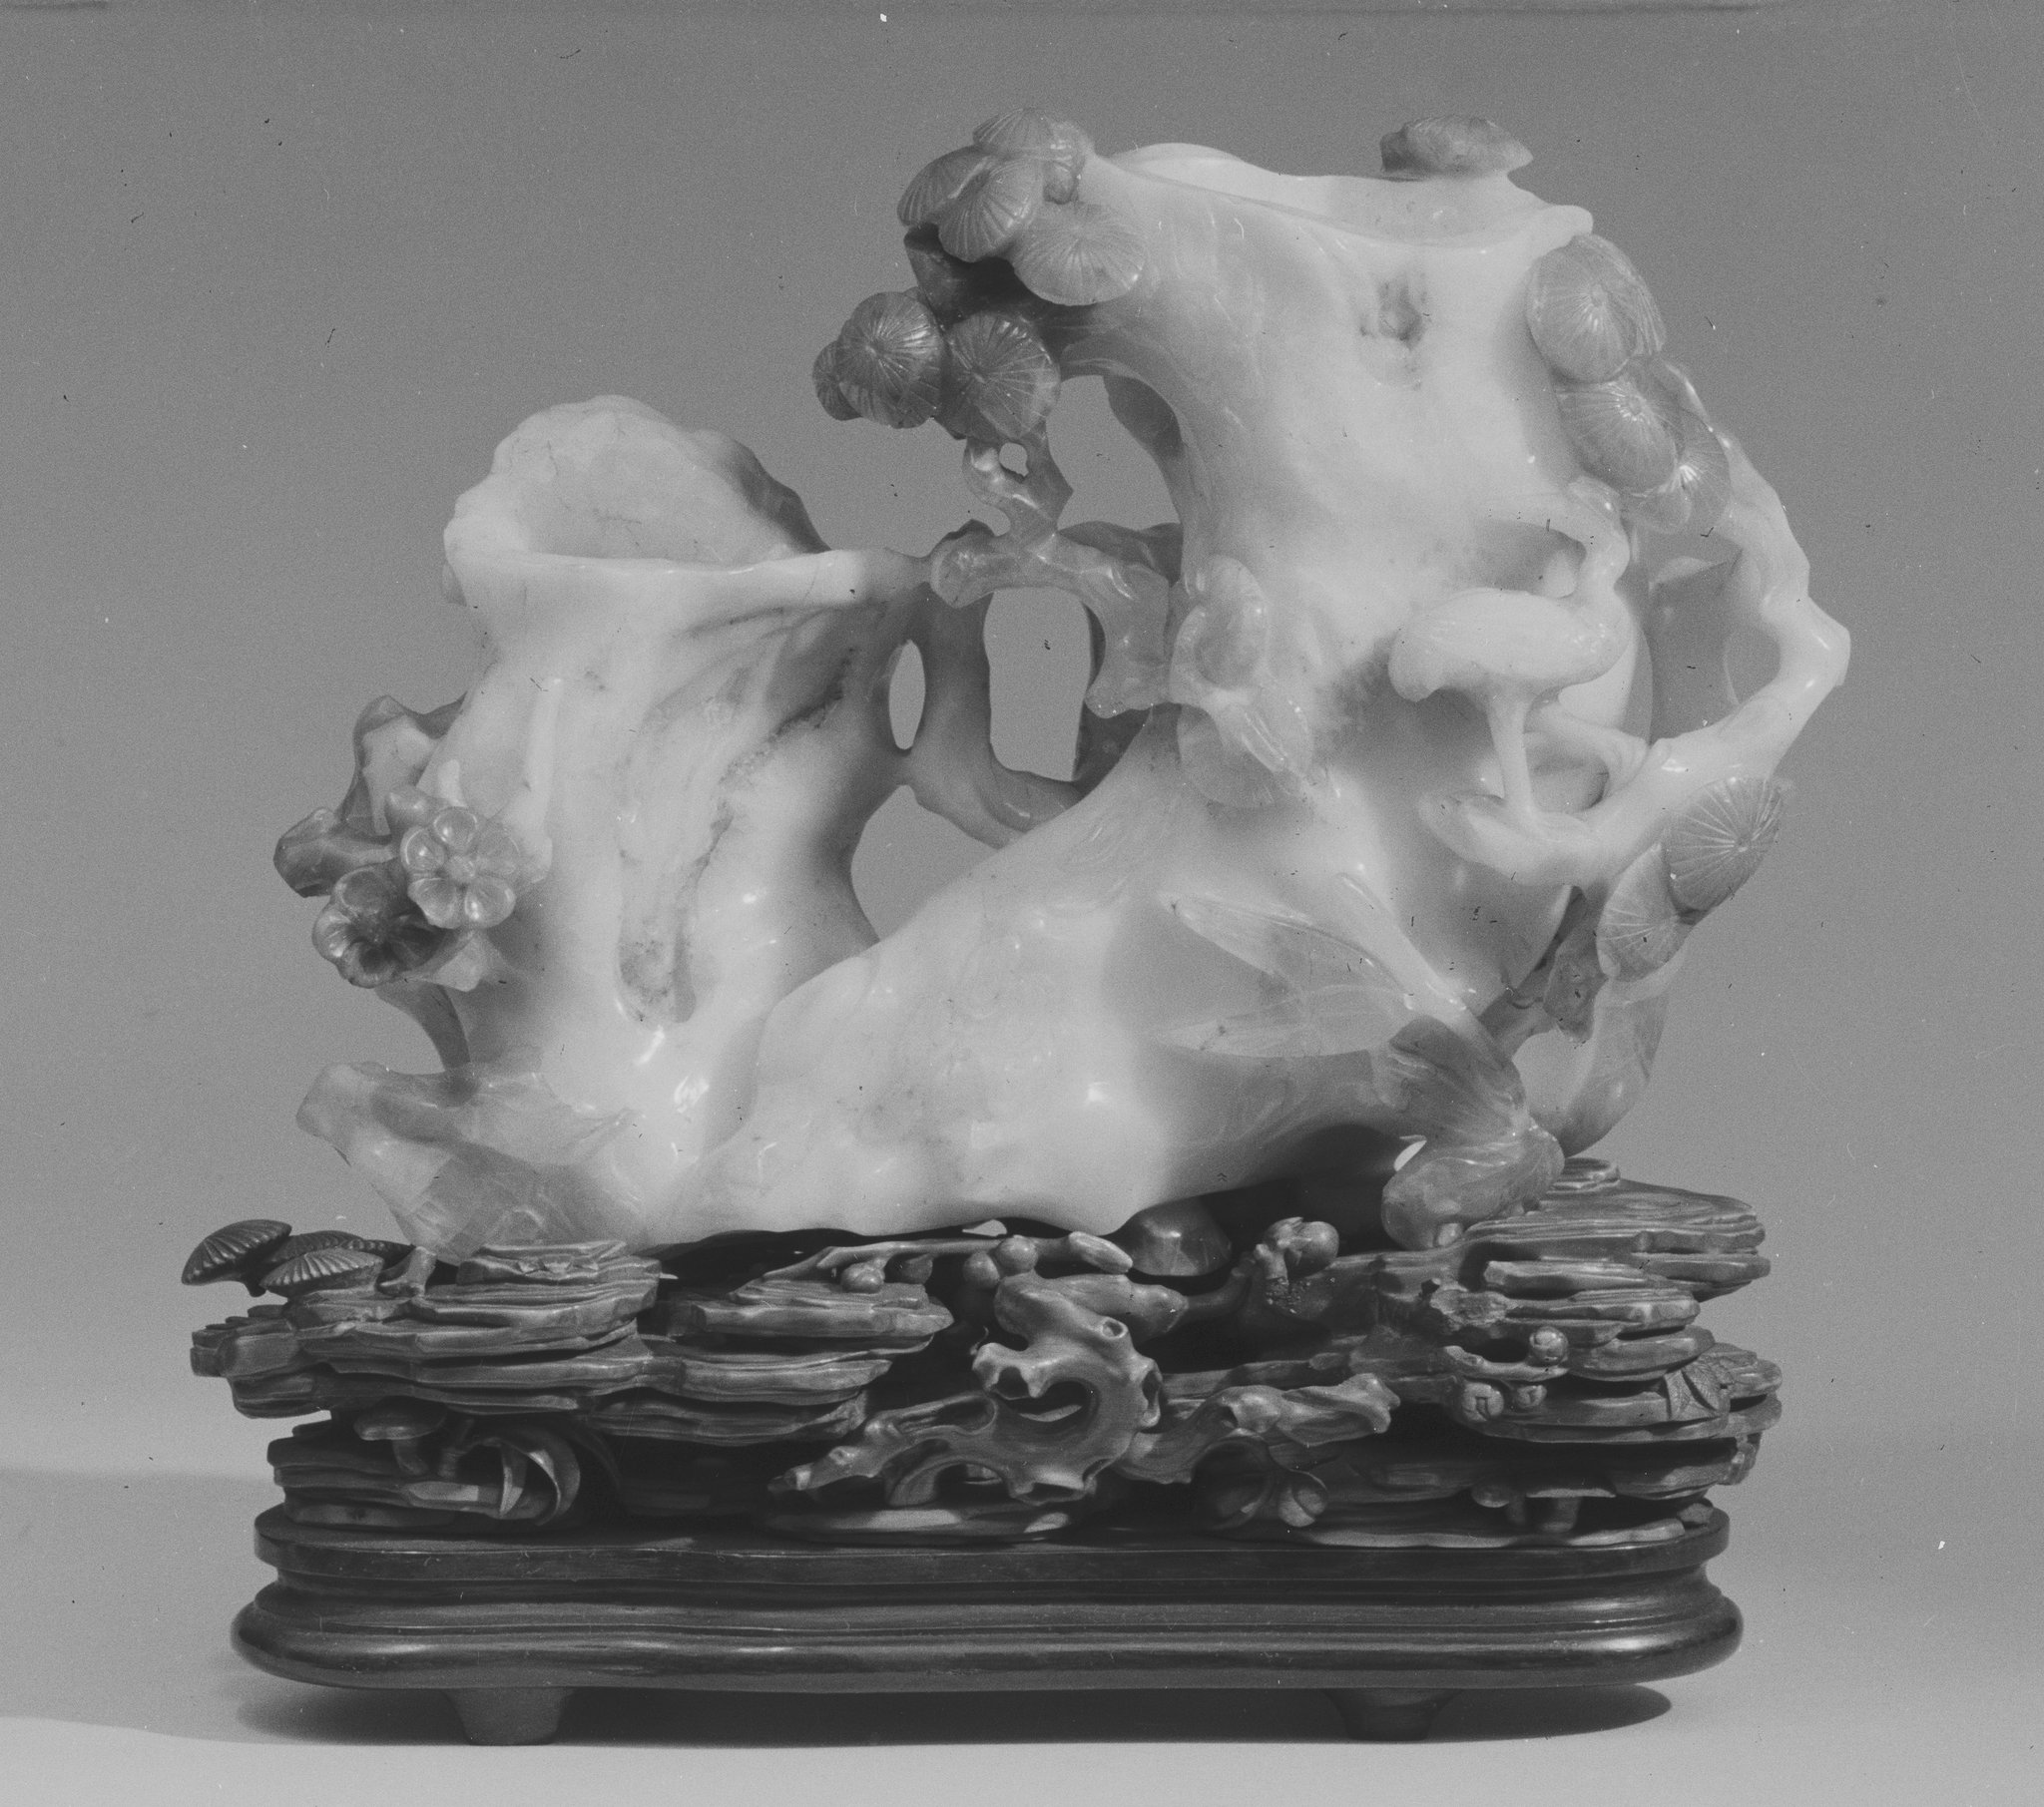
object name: flower holder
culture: chinese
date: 1801-1900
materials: gemstone, ivory, wood